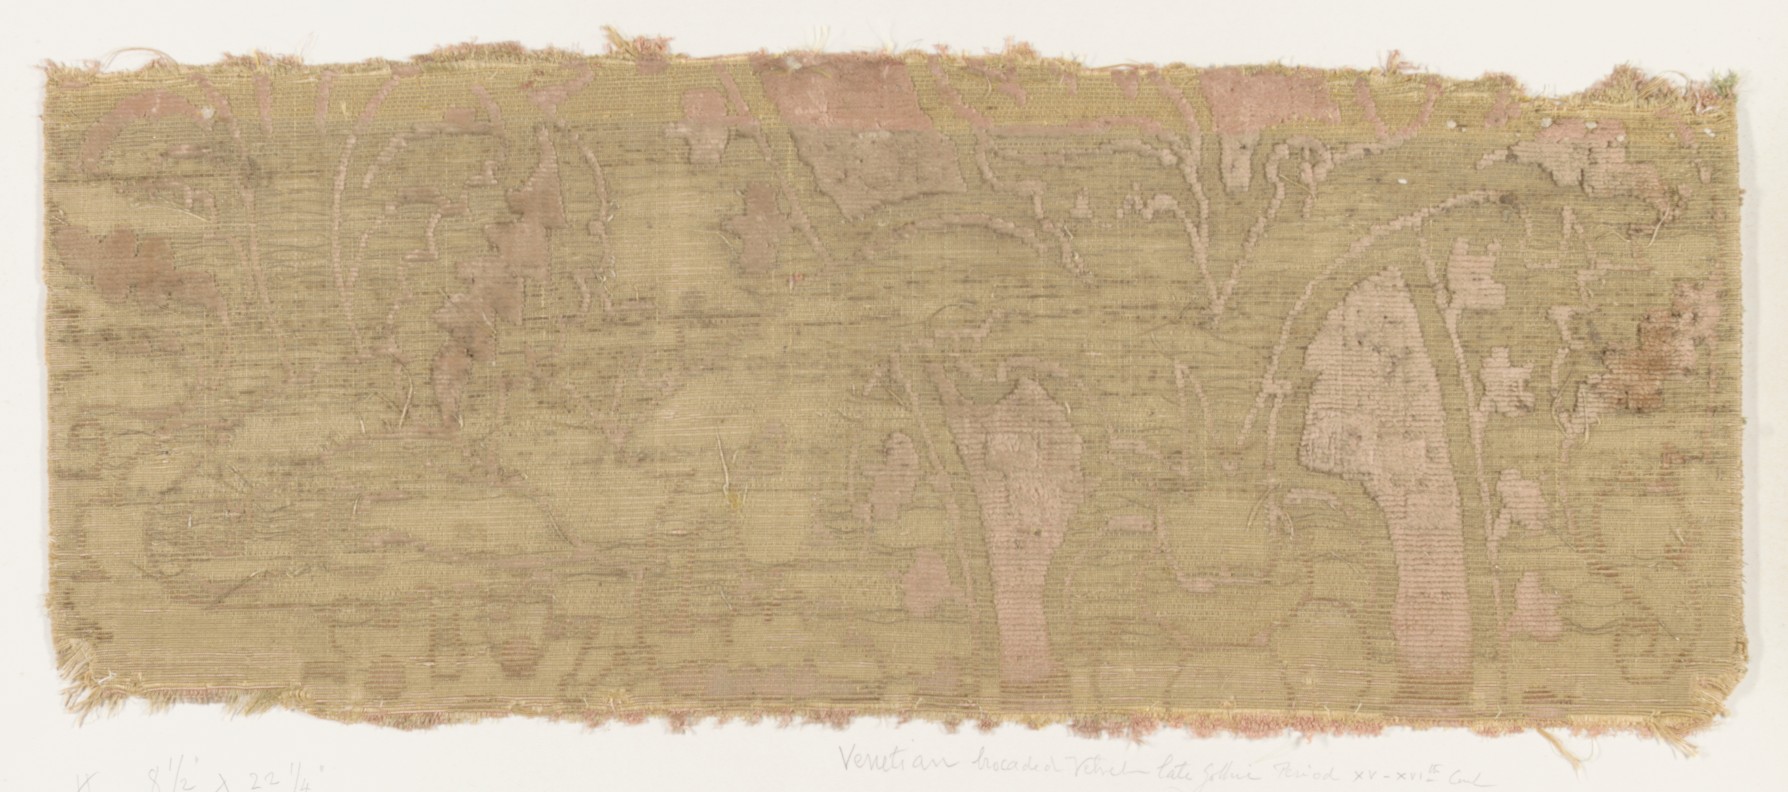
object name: fragment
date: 1401-1600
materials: metal thread, silk